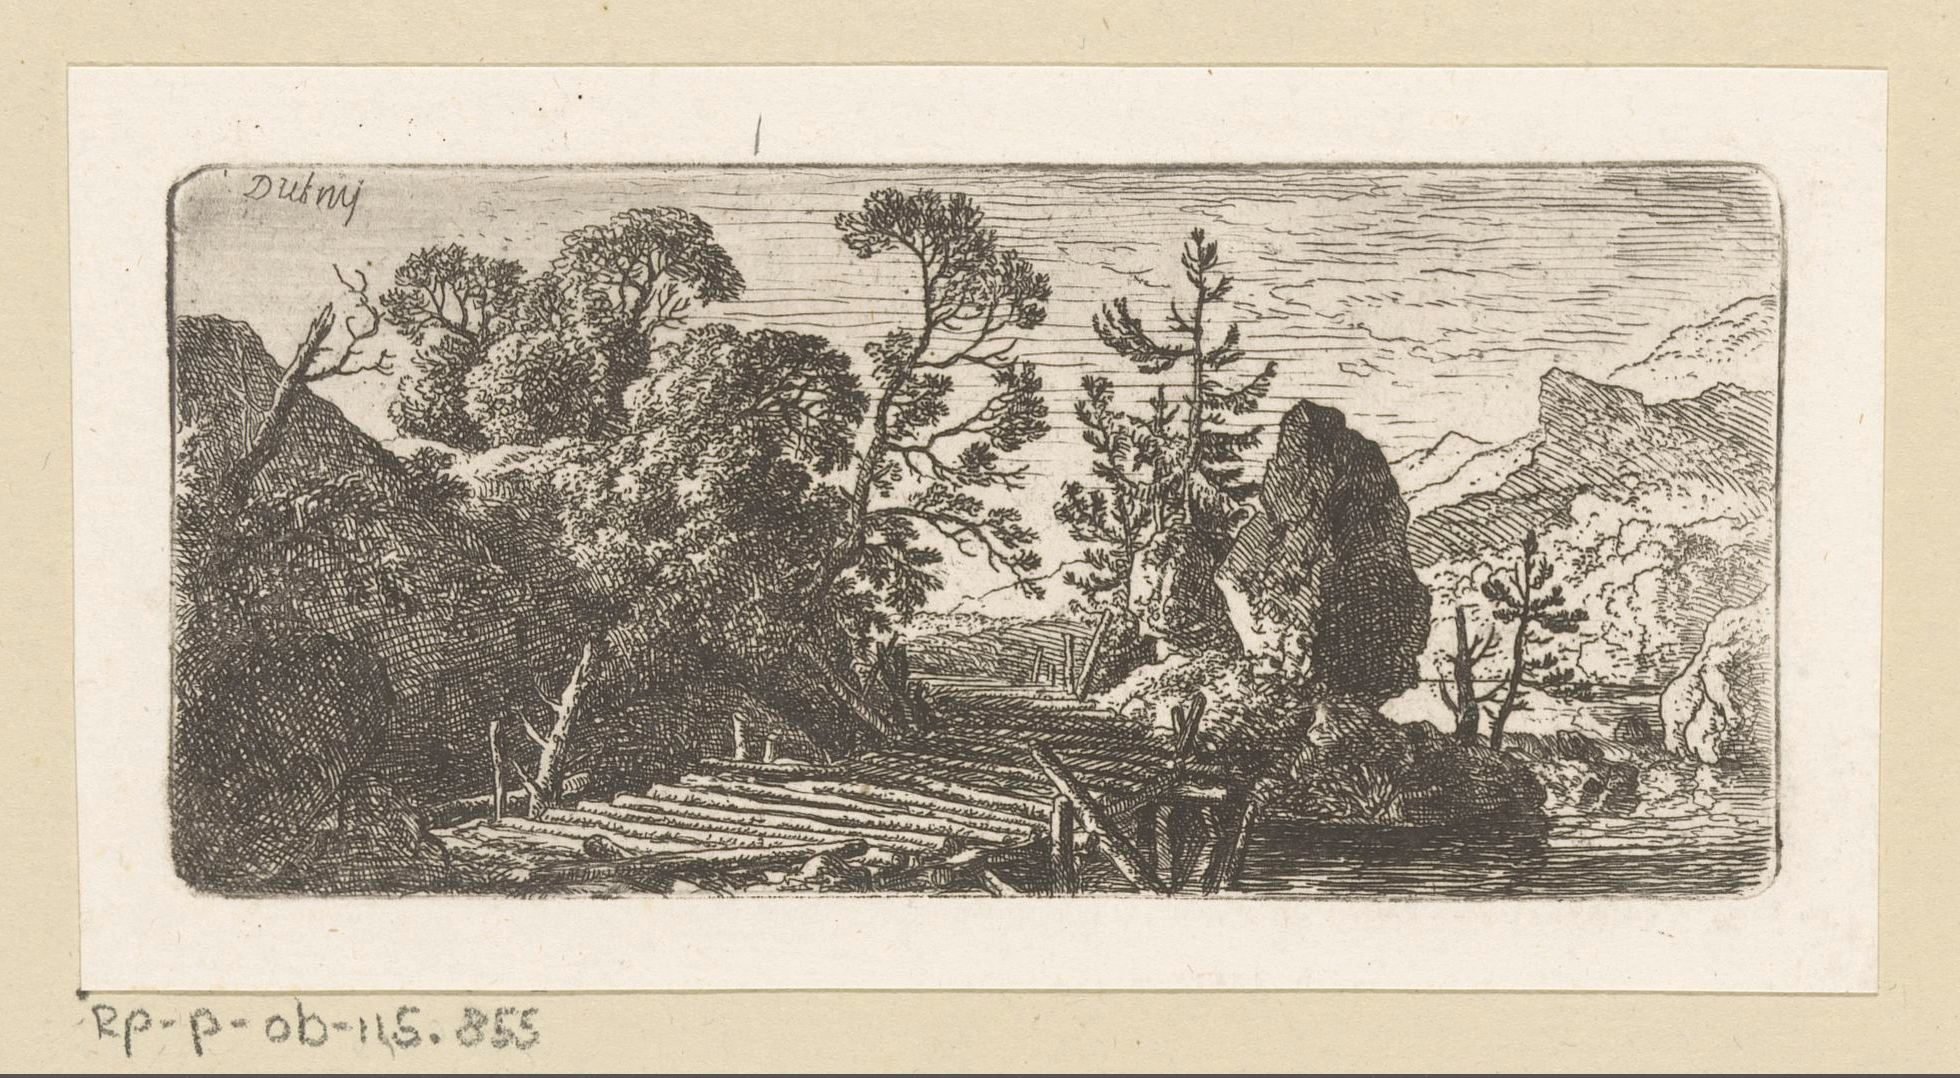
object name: print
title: Landschap met houten brug en rotsblok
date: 1722-1774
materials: paper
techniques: etching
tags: landscape with bridge, viaduct or aqueduct, boulder, stone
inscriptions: collector's mark: Lugt 240